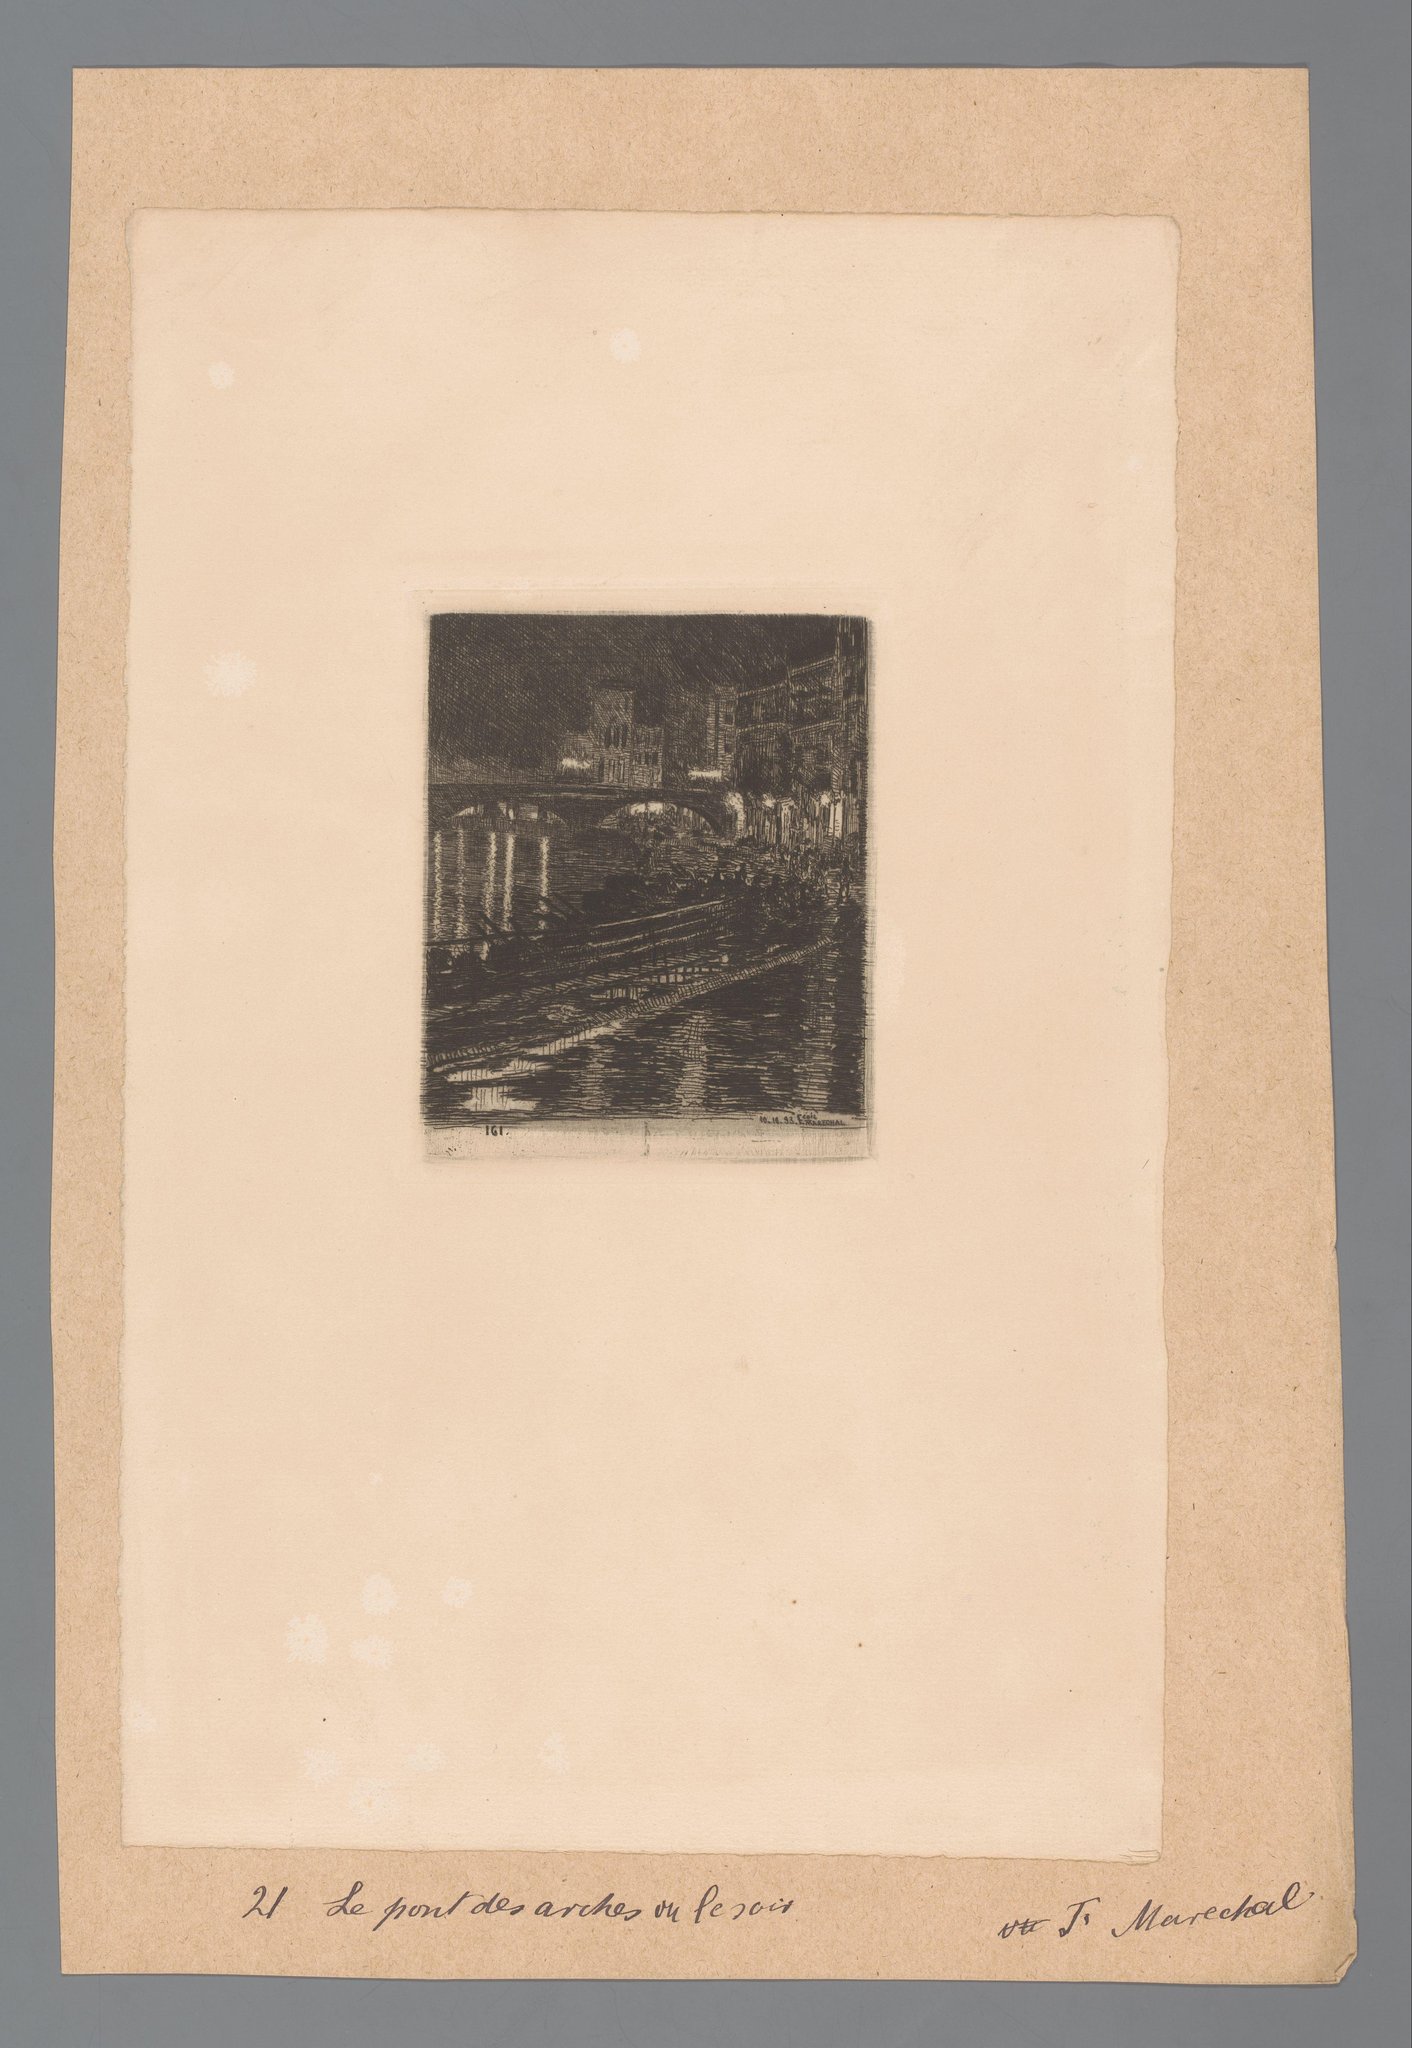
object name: print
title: Le Pont des Arches te Luik bij nacht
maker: françois maréchal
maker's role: print maker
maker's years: 1861-1945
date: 1893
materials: paper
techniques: etching, intaglio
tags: bridge, night, liège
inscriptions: collector's mark: Lugt 2228